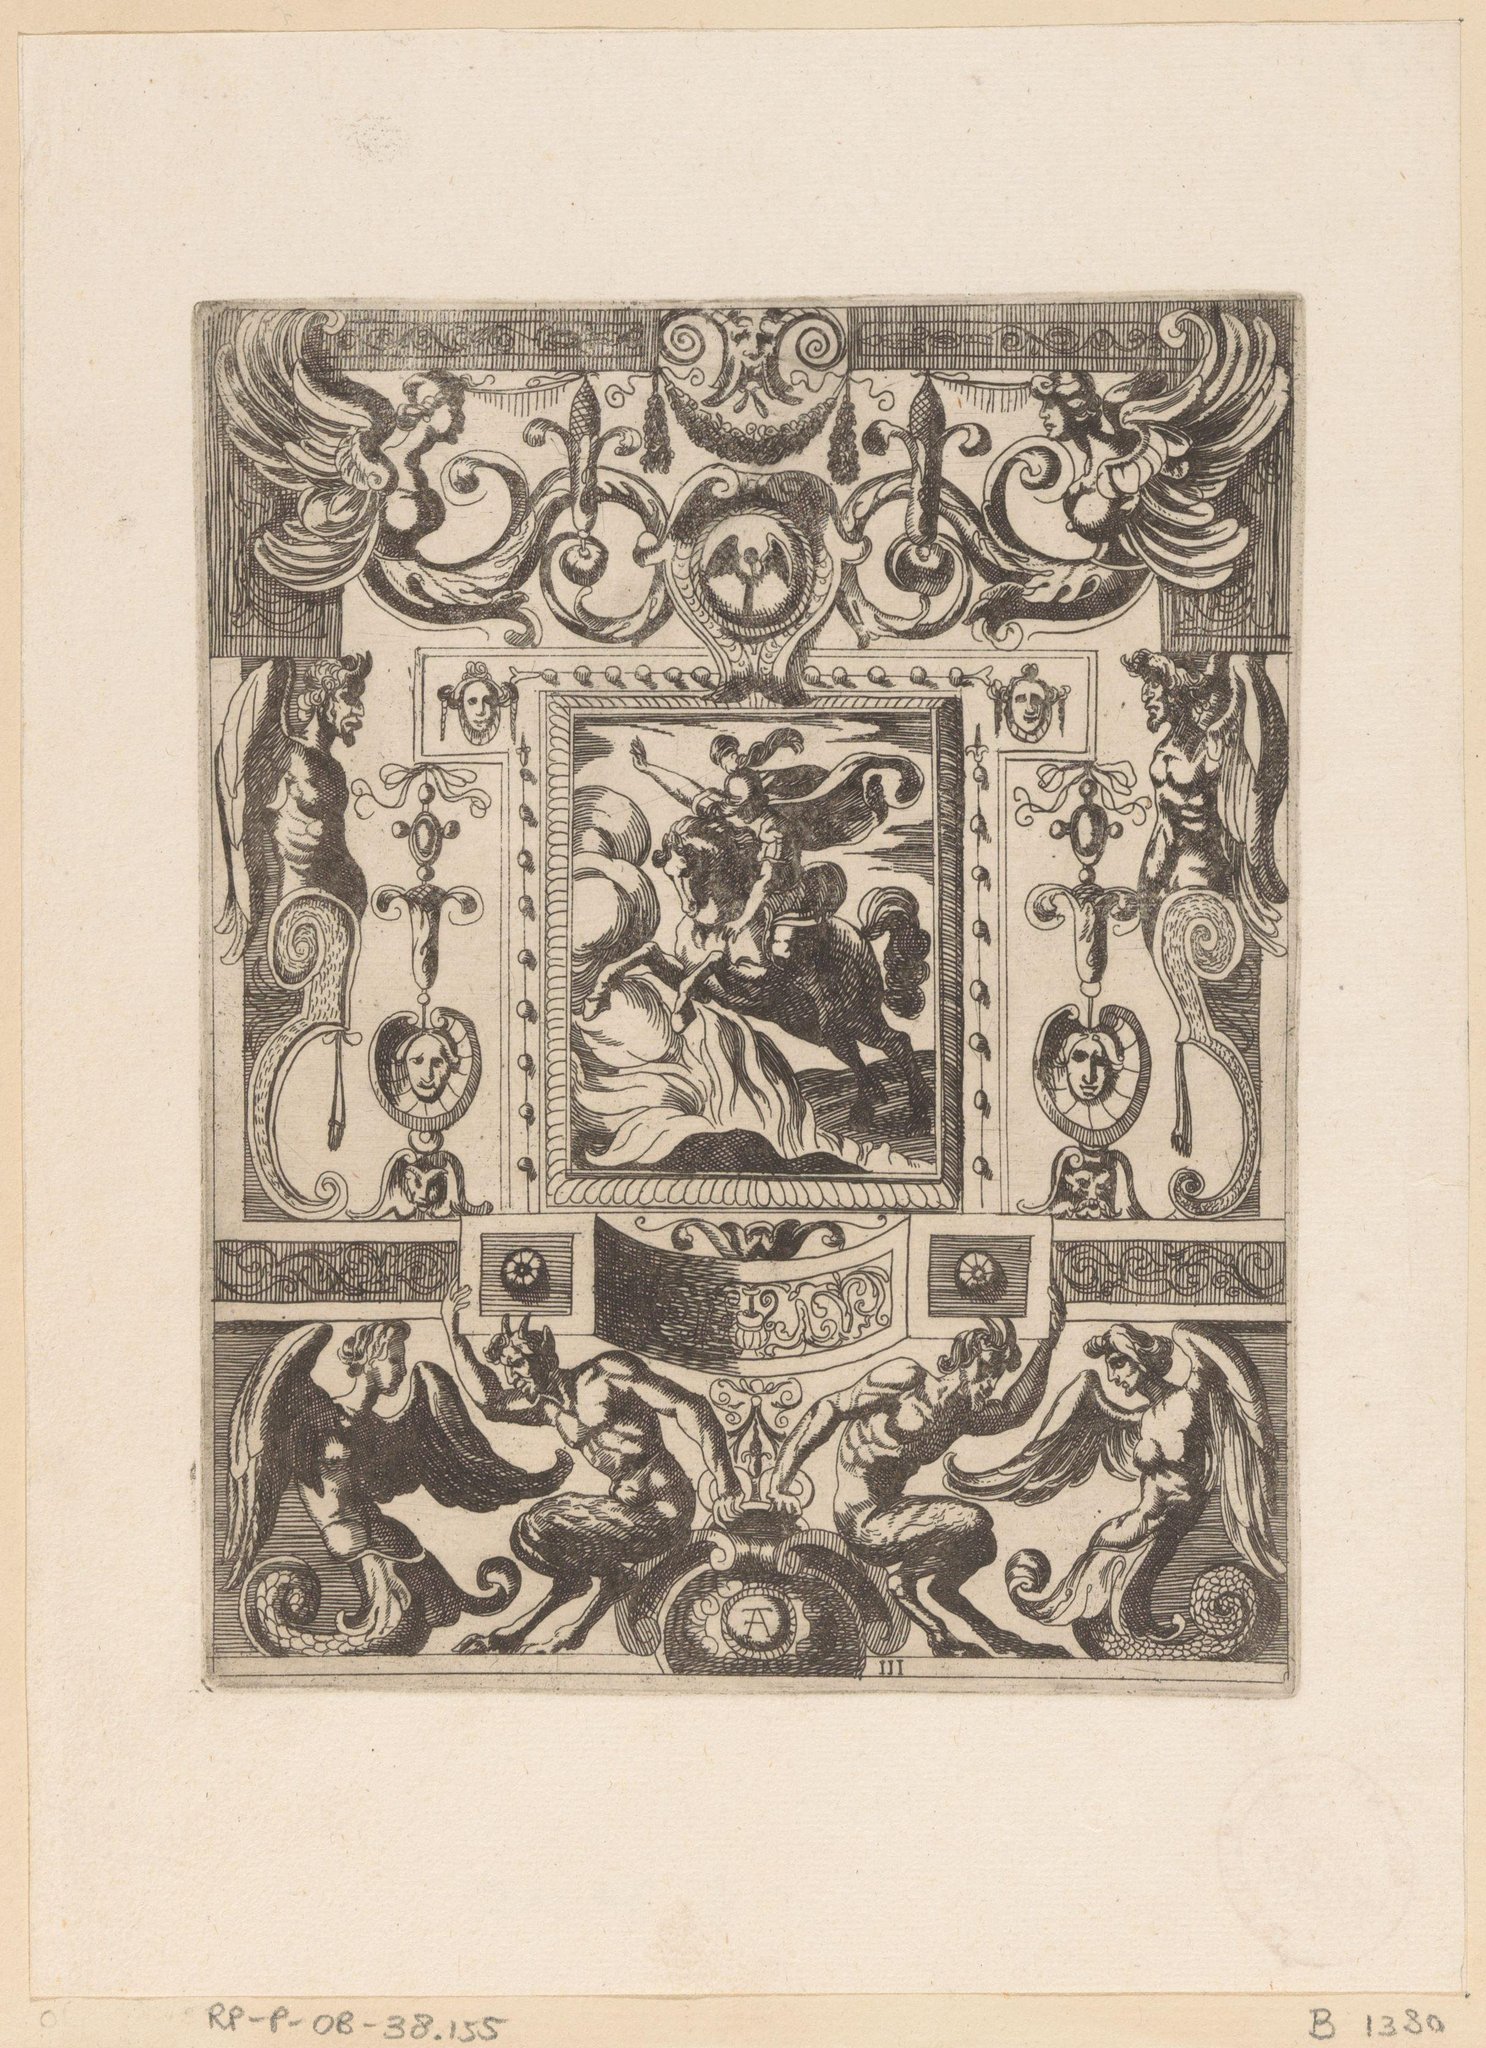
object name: print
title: Grotesk ornament met in het midden een gewapende ridder te paard over vlammen springend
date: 1624-1679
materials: paper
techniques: etching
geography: italy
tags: riding a horse, ass, or mule; rider, horseman, fabulous beings with wings - aa - female human figure, ornaments ~ art, satyr(s) (in general)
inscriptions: collector's mark: Lugt 240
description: Deze prent maakt deel uit van een reeks van tien prenten met groteske ornamenten. Deze prenten zijn kopieën uitgegeven door Frans van den Wijngaerde naar een reeks prenten door Antonio Tempesta met de titel 'Esemplare del disegno in gratia dei Principianti nell'arte della pitura et scultura'. De originele serie was uitgegeven door Giovanni Orlandi in 1602.